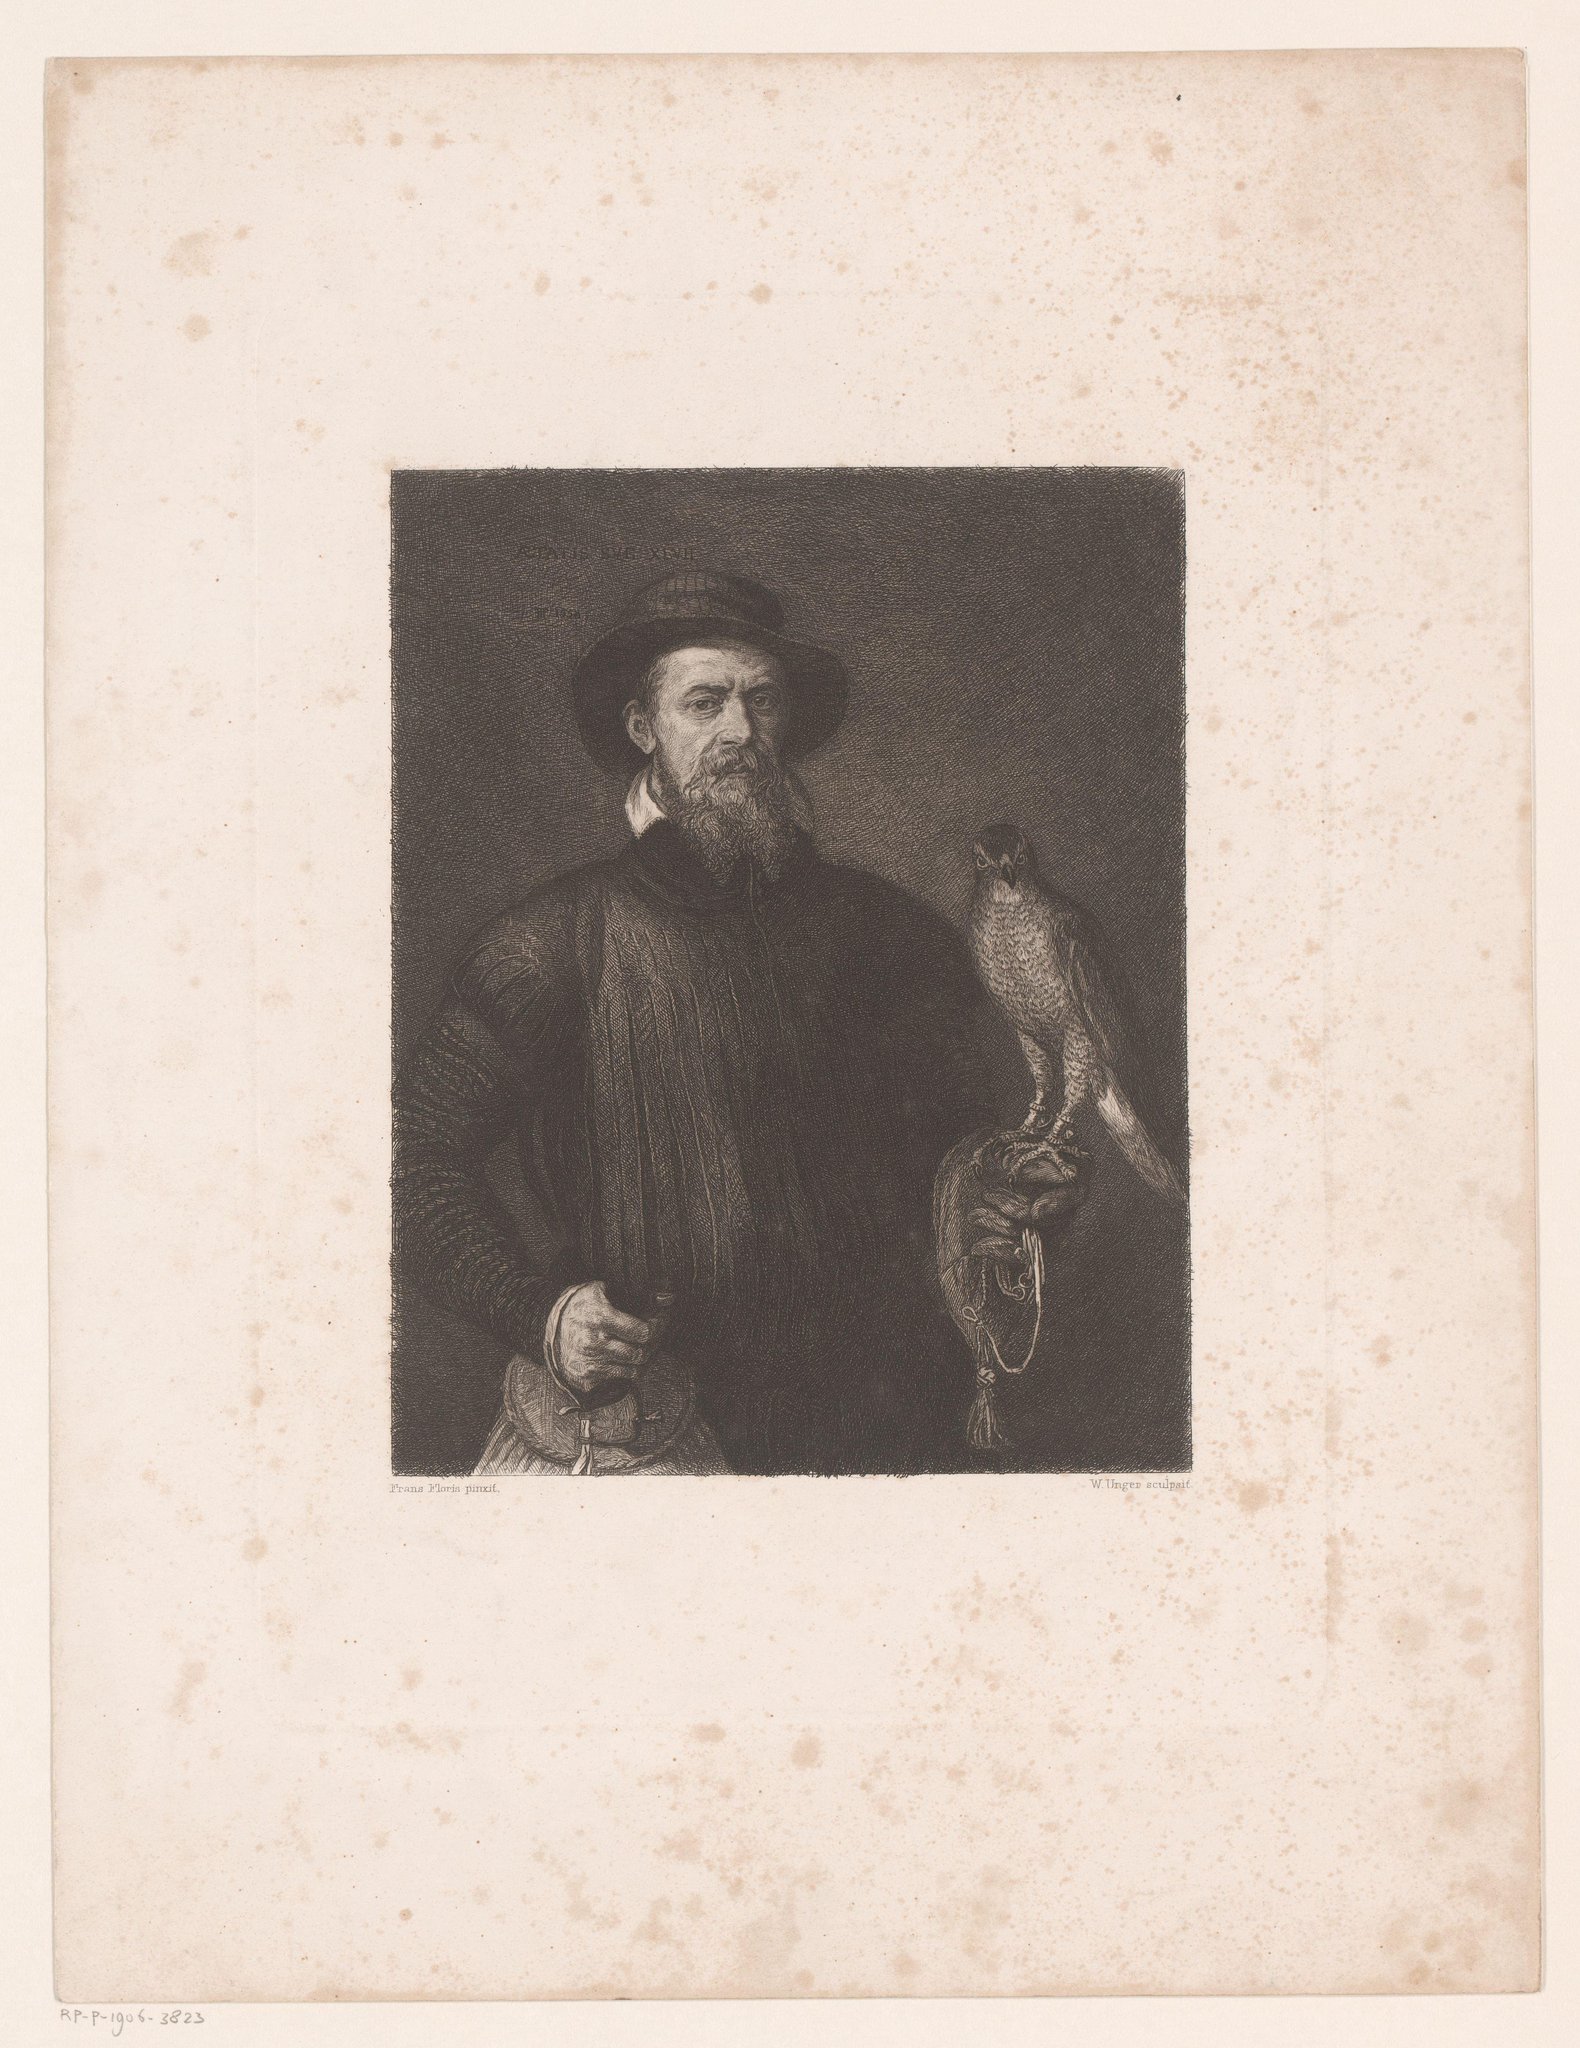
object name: print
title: Portret van een onbekende man met een valk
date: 1847-1889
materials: paper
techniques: etching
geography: germany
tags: predatory birds: falcon, bird hunting, game bag, anonymous historical person portrayed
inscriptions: collector's mark: Lugt 2228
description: Prent naar het schilderij door Frans Floris I in het Herzog Anton Ulrich-Museum Braunschweig (inv.nr. GK 39).